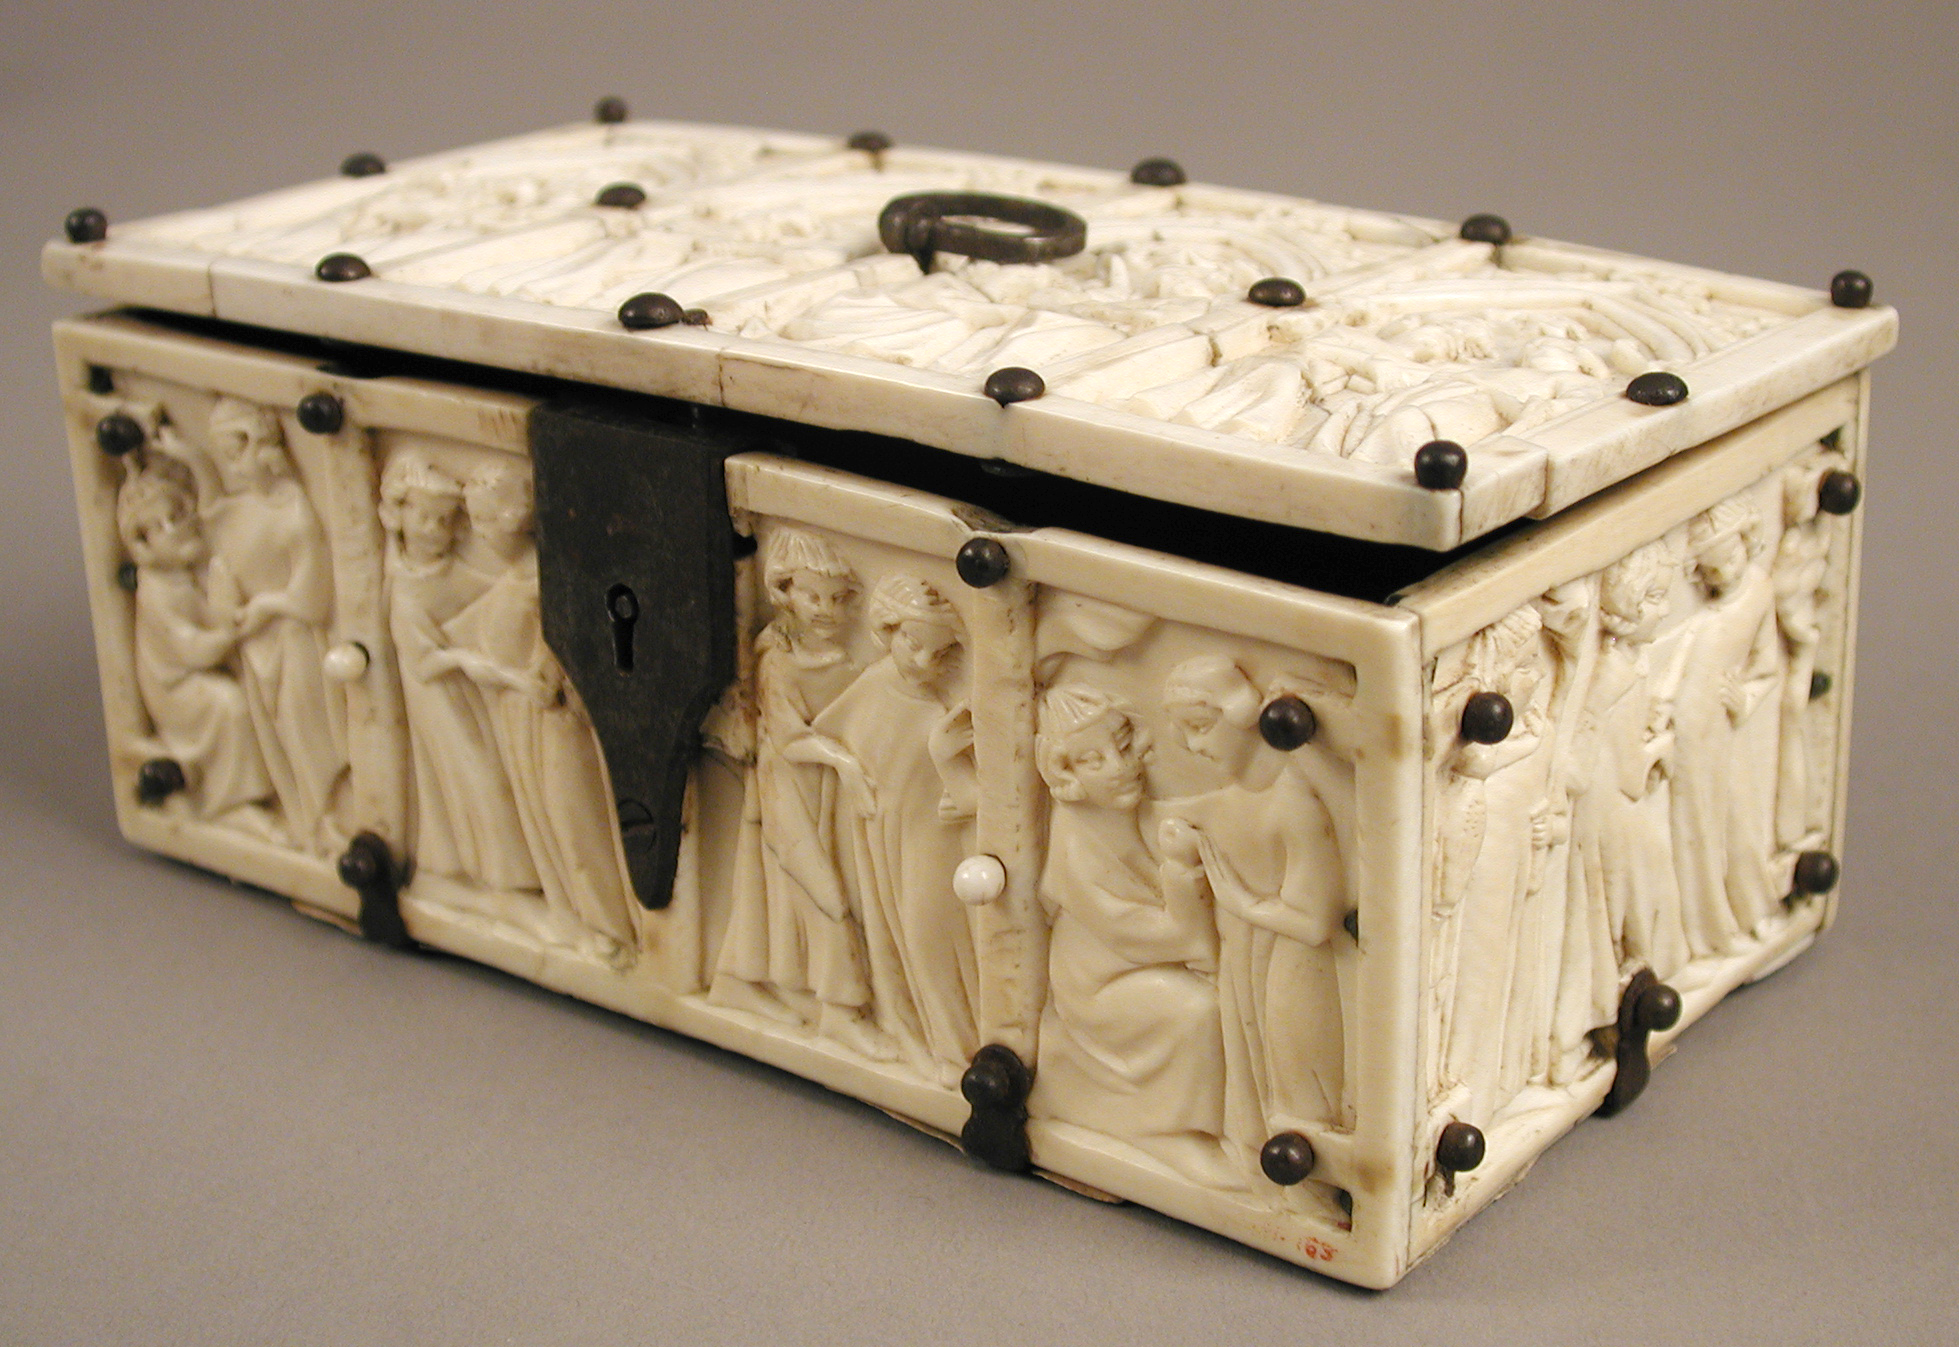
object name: casket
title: Box with Courting Couples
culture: french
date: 1301-1400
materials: cardboard, iron, ivory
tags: couples,men,women